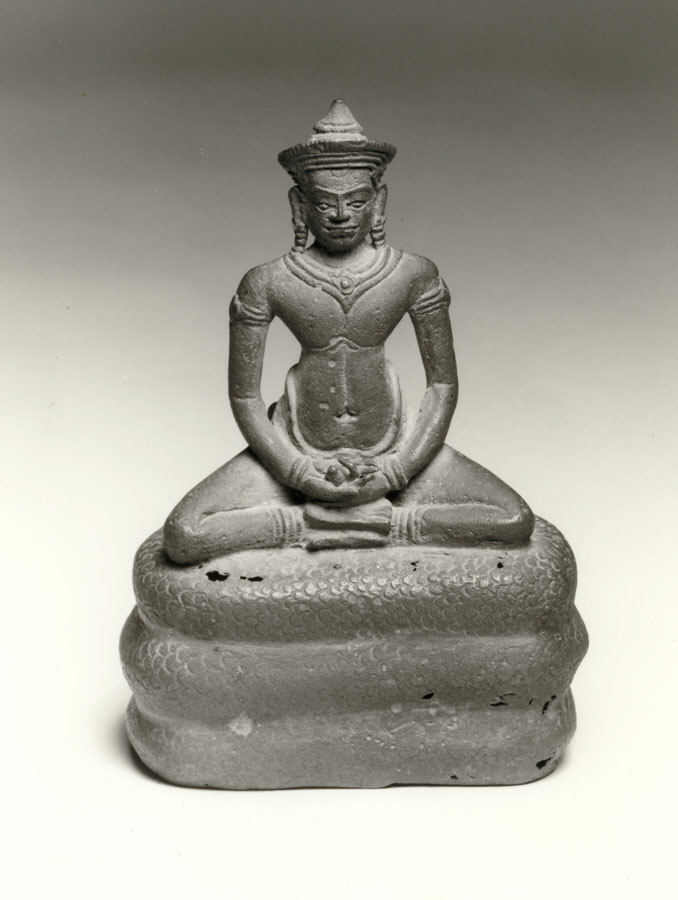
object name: figurine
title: Buddha Seated on the Coils of a Naga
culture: cambodian or thai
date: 1101-1125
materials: bronze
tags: buddhism,buddha